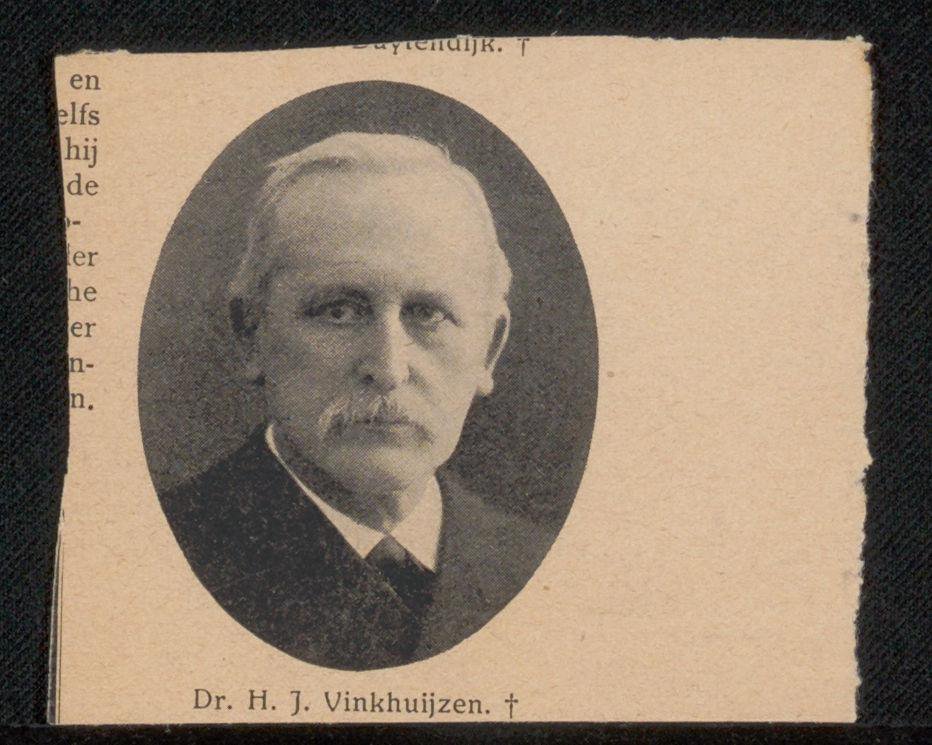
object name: print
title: Portret uit archief Philip Zilcken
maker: Anonymous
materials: paper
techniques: autotype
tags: the hague, painter, draughtsman, philip zilcken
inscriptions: collector's mark: ‘RPK’